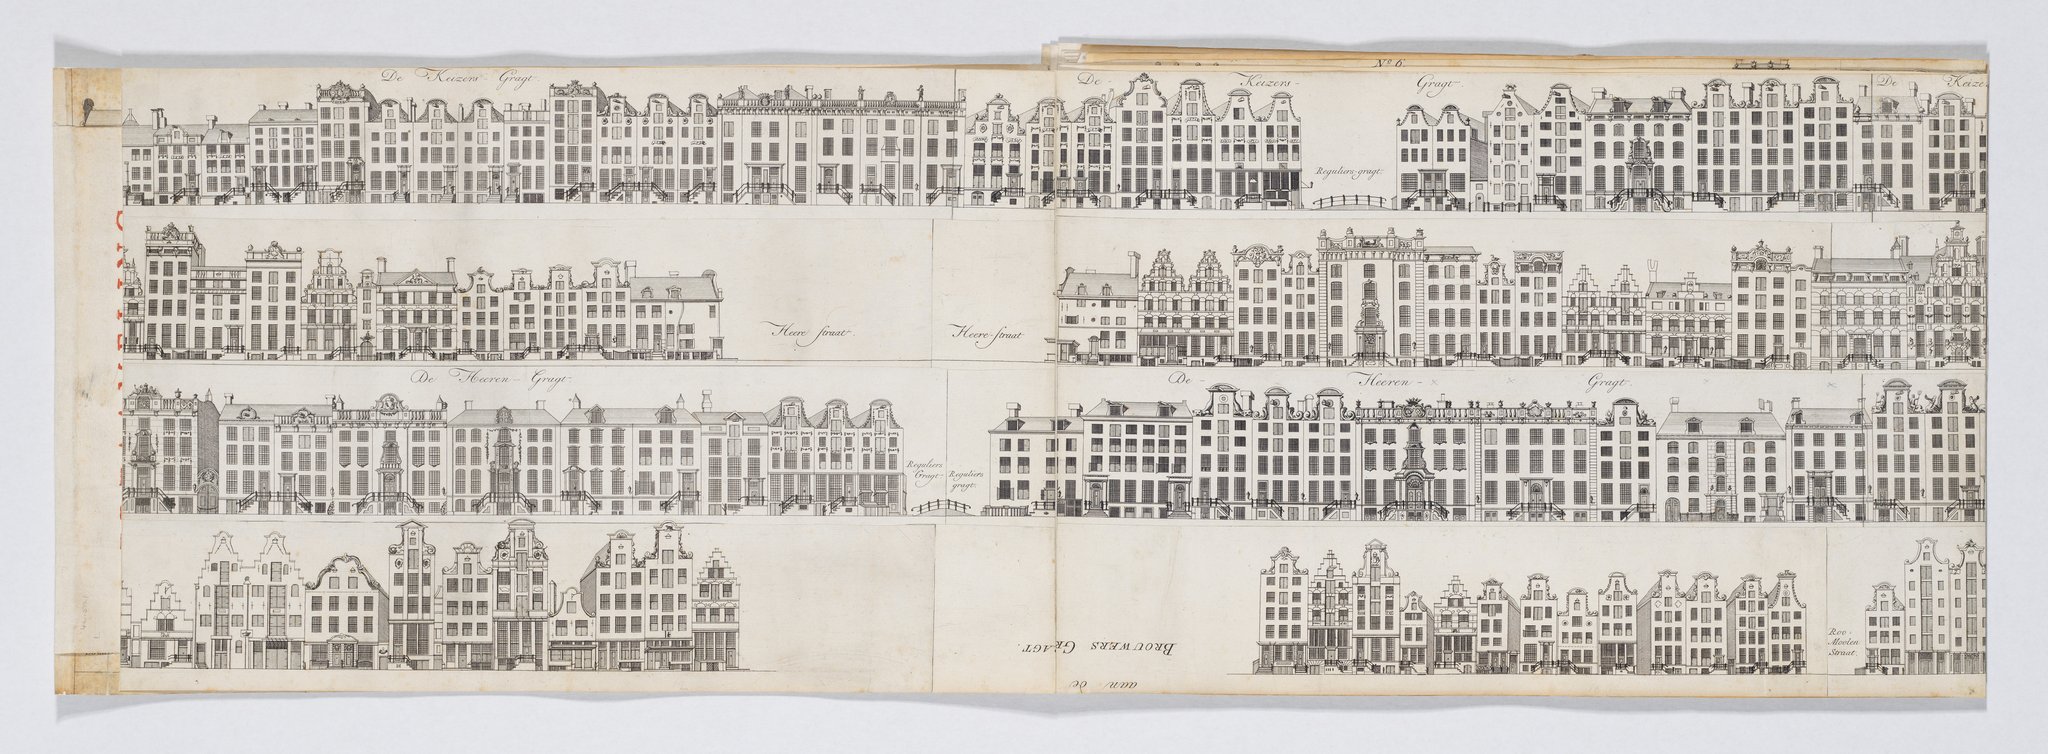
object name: book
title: Verzaameling van alle de huizen (...) langs de (...) grachten der stadt Amsteldam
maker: jan caspar philips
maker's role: illustrator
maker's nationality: dutch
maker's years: 1700-1775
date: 1768-1771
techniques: engraving